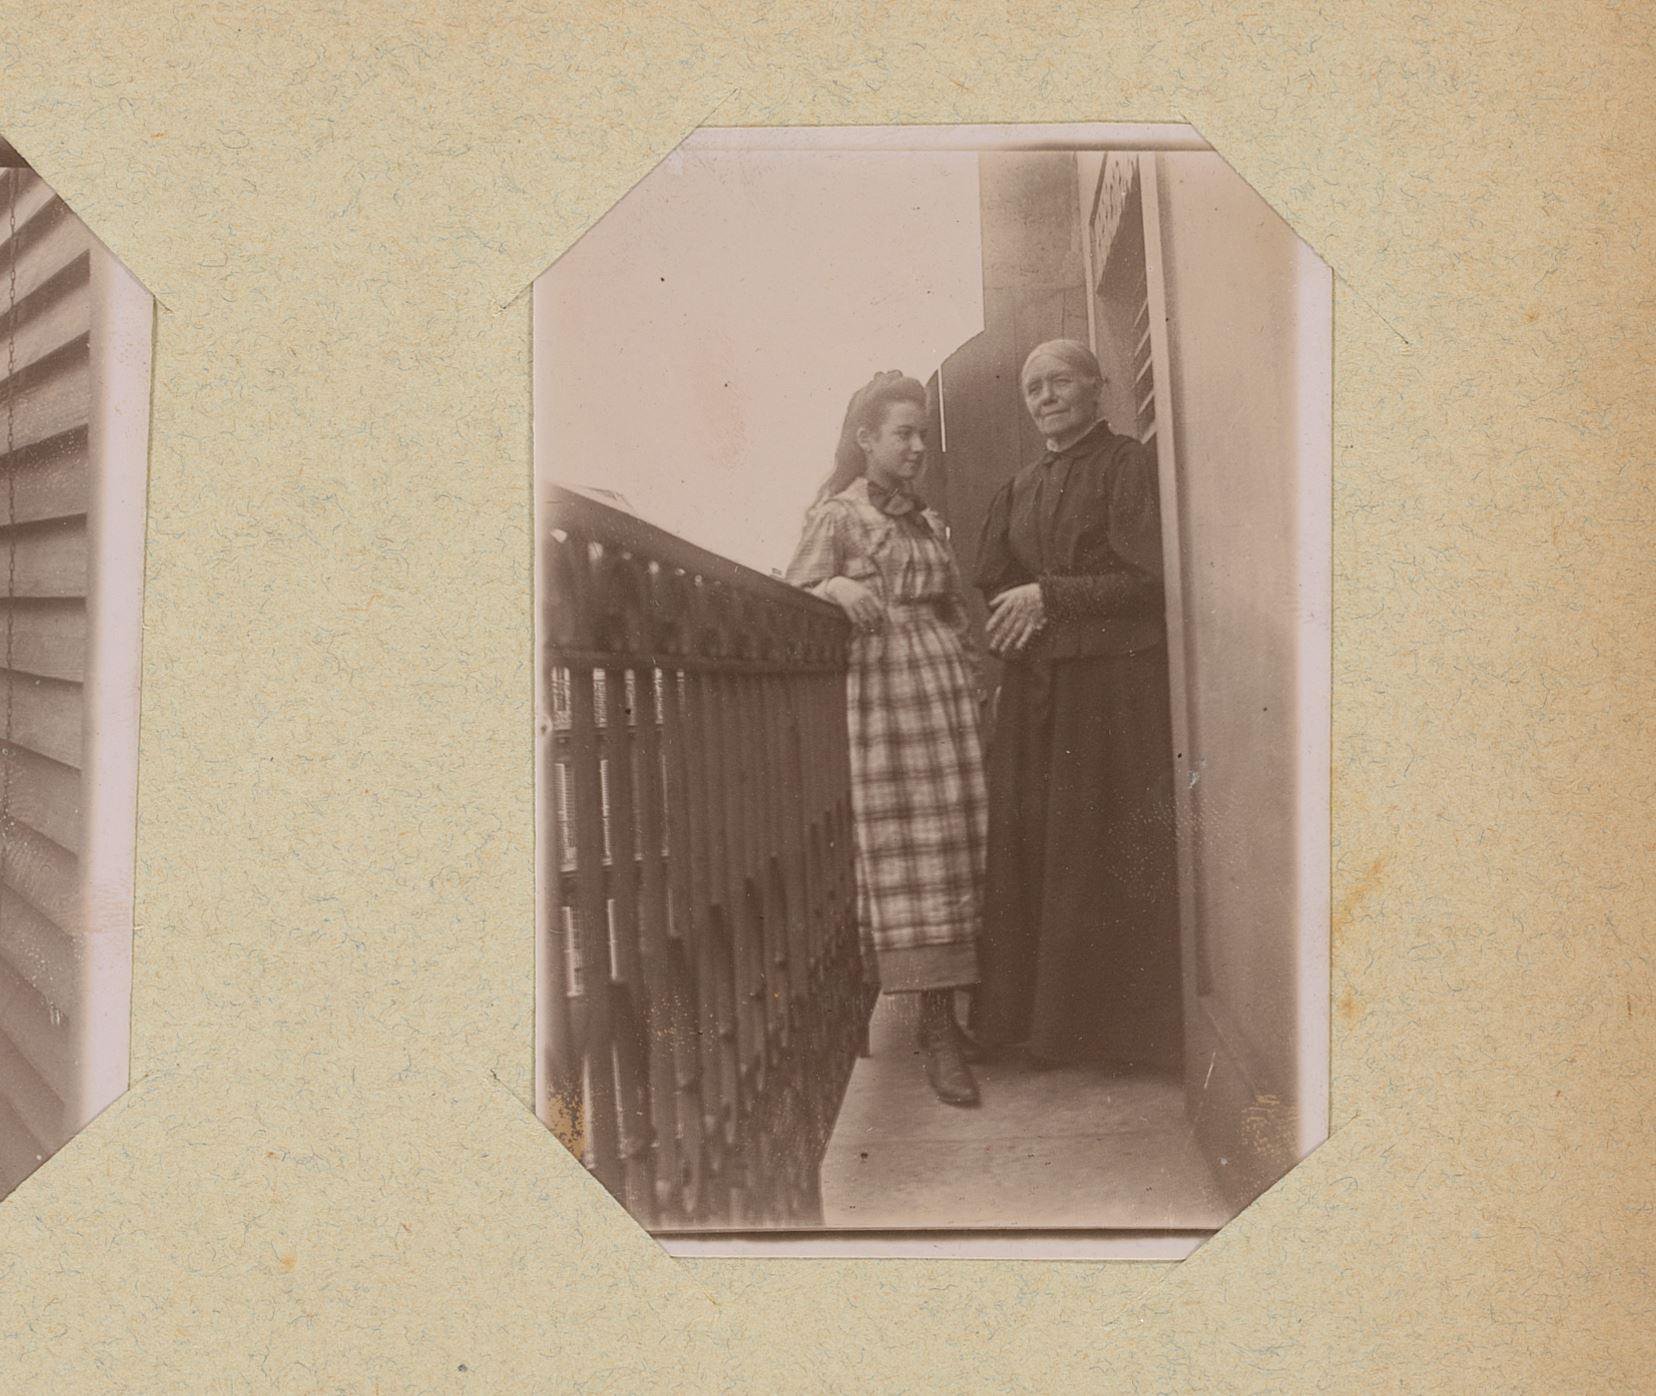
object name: album leaf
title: Portret van een meisje en een oude vrouw op een balkon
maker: Anonymous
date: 1897-1900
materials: paper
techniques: gelatin silver print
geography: france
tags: historical persons, girl (child between toddler and youth), old woman, france